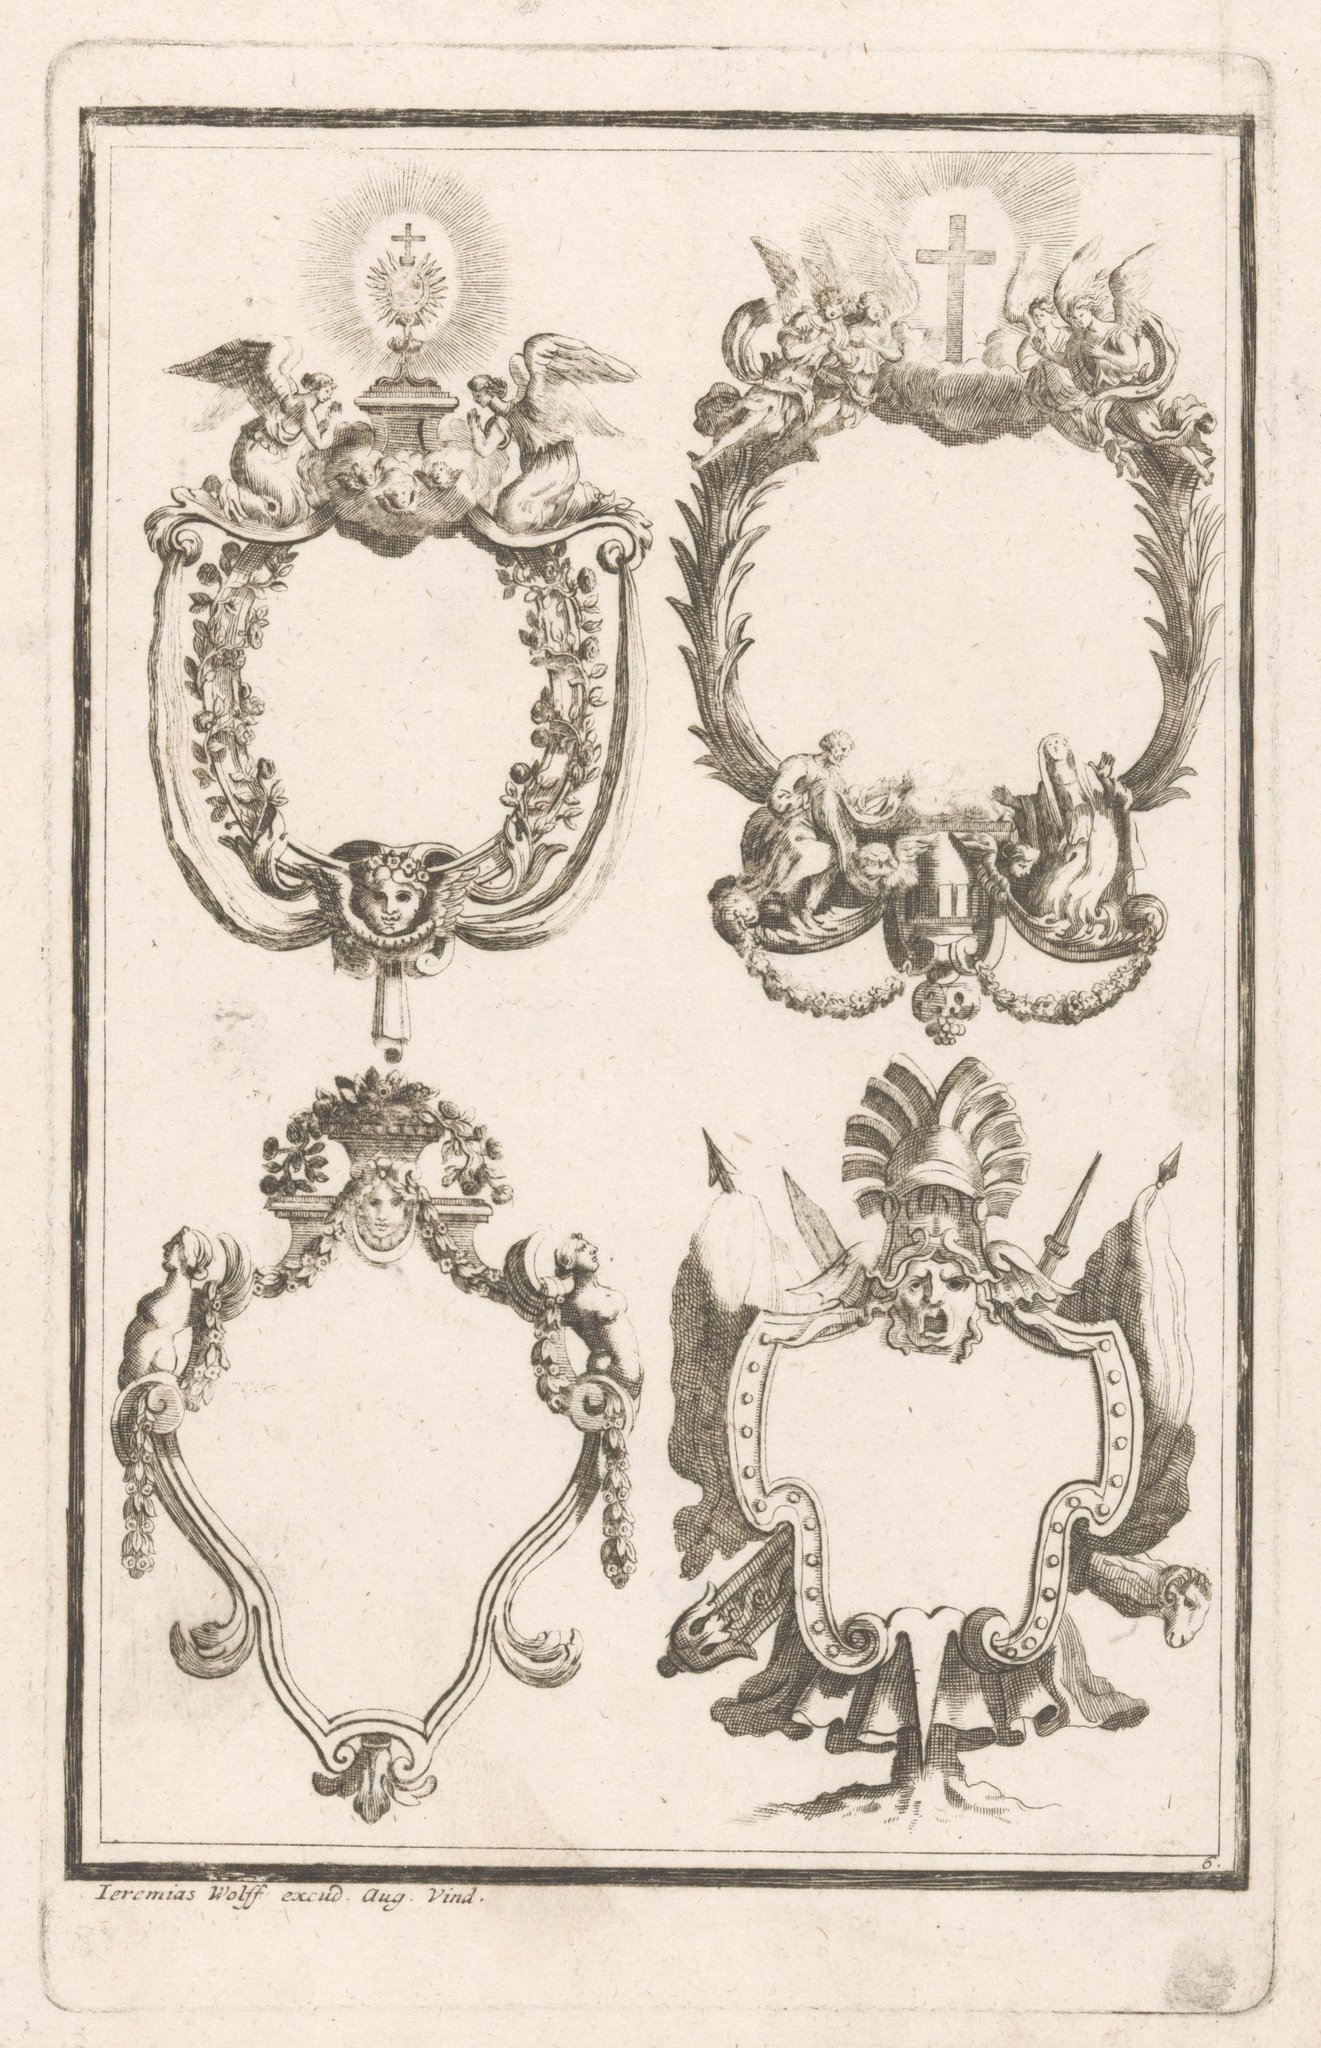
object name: ornament print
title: Vier cartouches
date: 1678-1724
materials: paper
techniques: engraving, etching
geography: augsburg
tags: helmet, cross as symbol of christ, ostensorium, monstrance, holy family (alone), 'trinitas terrestris', ornament ~ cartouche, angels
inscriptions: collector's mark: Lugt 2228, collector's mark: Lugt 2760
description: Vier geornamenteerde cartouches. Links boven met twee engelen aan weerszijden van een stralenmonstrans. Rechts met vier engelen rondom een kruis en Maria, Josef en het Christuskund. Links onder met twee halfweergegeven vrouwen en een mand met bloemen. Rechts met een gevleugeld hoofd met een helm, vlaggen en wapens.